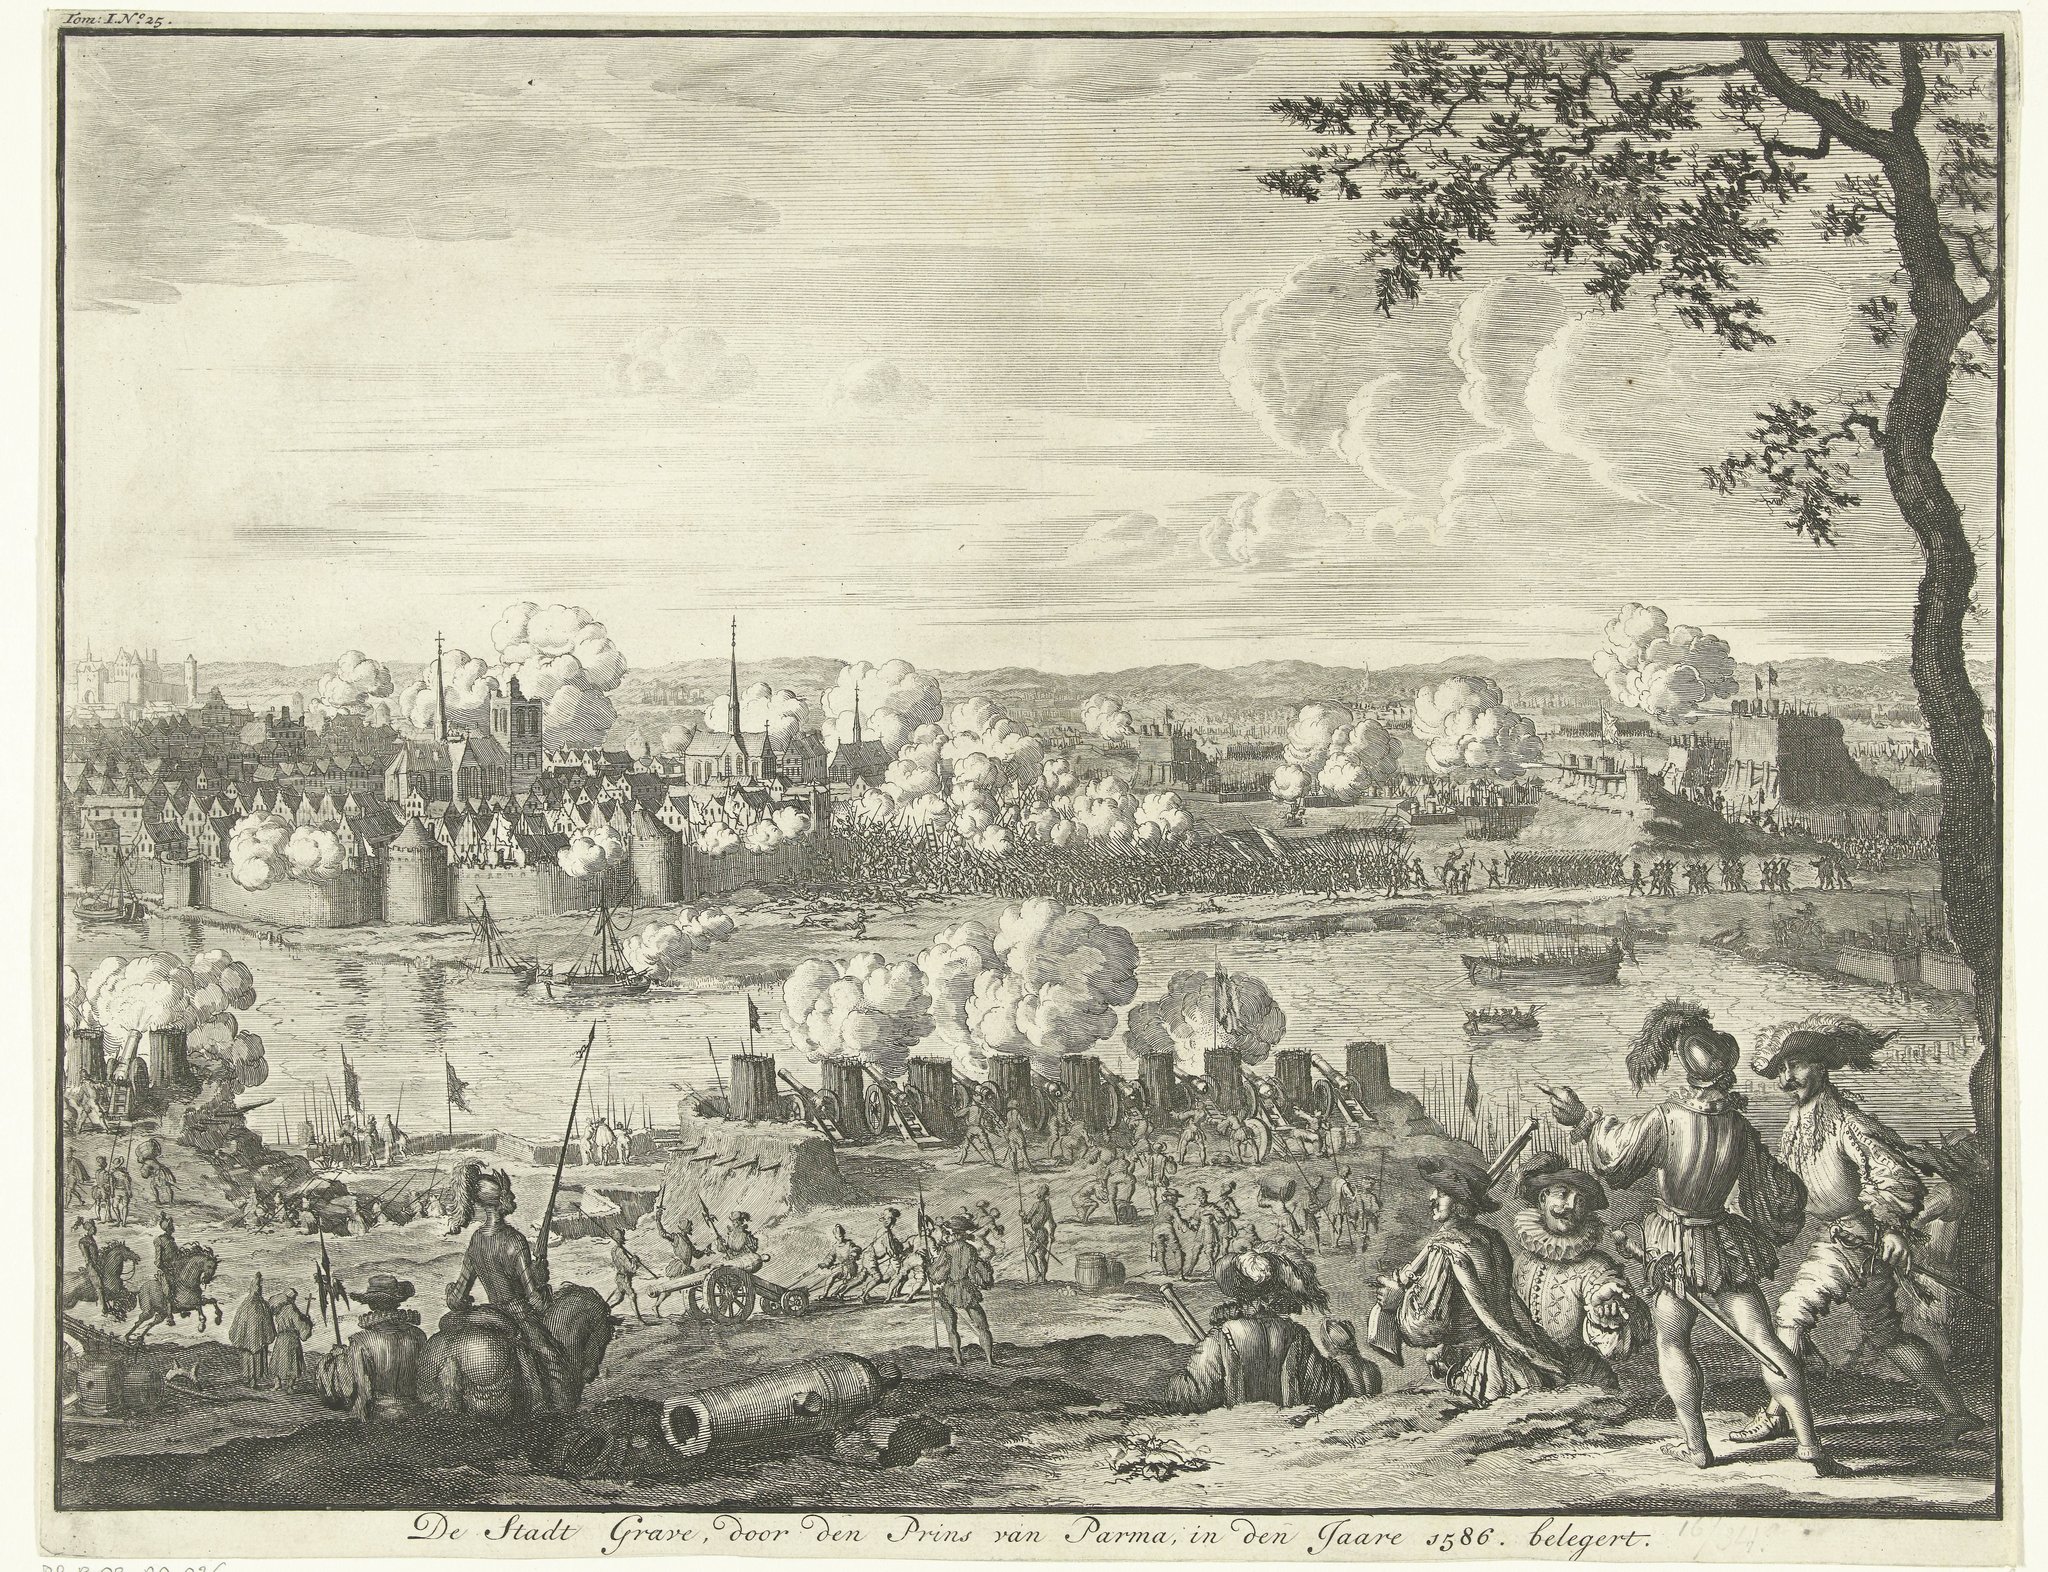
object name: print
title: Beleg en bestorming van Grave door de hertog van Parma, 1586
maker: jan luyken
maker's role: draughtsman, print maker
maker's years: 1649-1712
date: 1678-1680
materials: paper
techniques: engraving, etching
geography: northern netherlands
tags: rome, alessandro farnese (landvoogd van de nederlanden en hertog van parma en piacenza), siege, position war, capture of city (after the siege), grave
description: Gebruikt als illustratie in: J. le Clerc, Geschiedenissen der Vereenigde Nederlanden, sedert den aanvang van die Republyk tot op den Vrede van Utrecht in 't jaar 1713 en het Tractaat van Barriere in 't jaar 1715 gesloten, Z. Chatelain, Amsterdam 1730, 3 delen, Tom. I. No. 25.